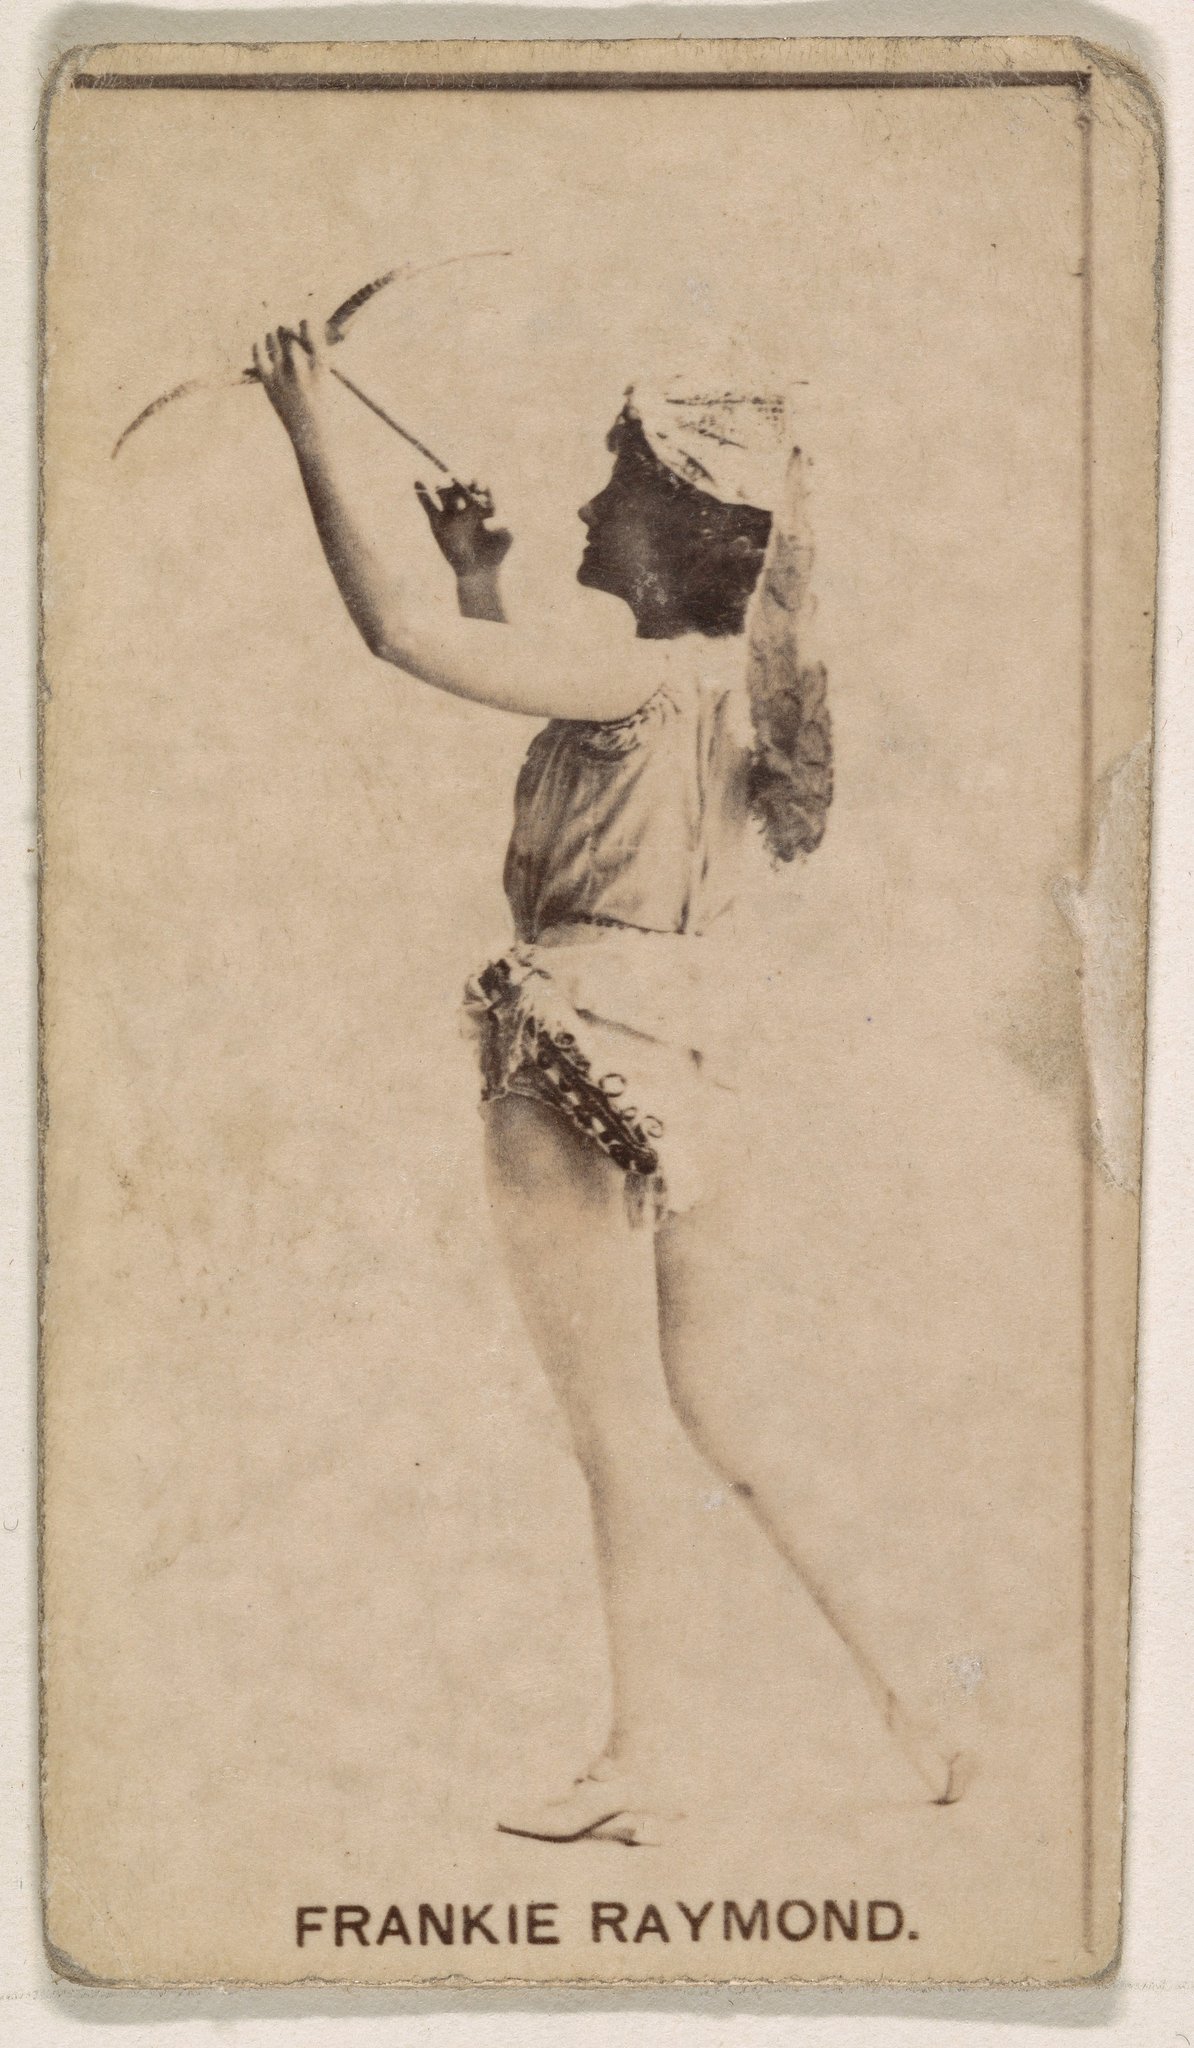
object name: photograph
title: Frankie Raymond, from the Actresses series (N245) issued by Kinney Brothers to promote Sweet Caporal Cigarettes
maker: kinney brothers tobacco company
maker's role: publisher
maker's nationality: american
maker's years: 1869-2011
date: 1890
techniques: albumen silver print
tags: women,actresses